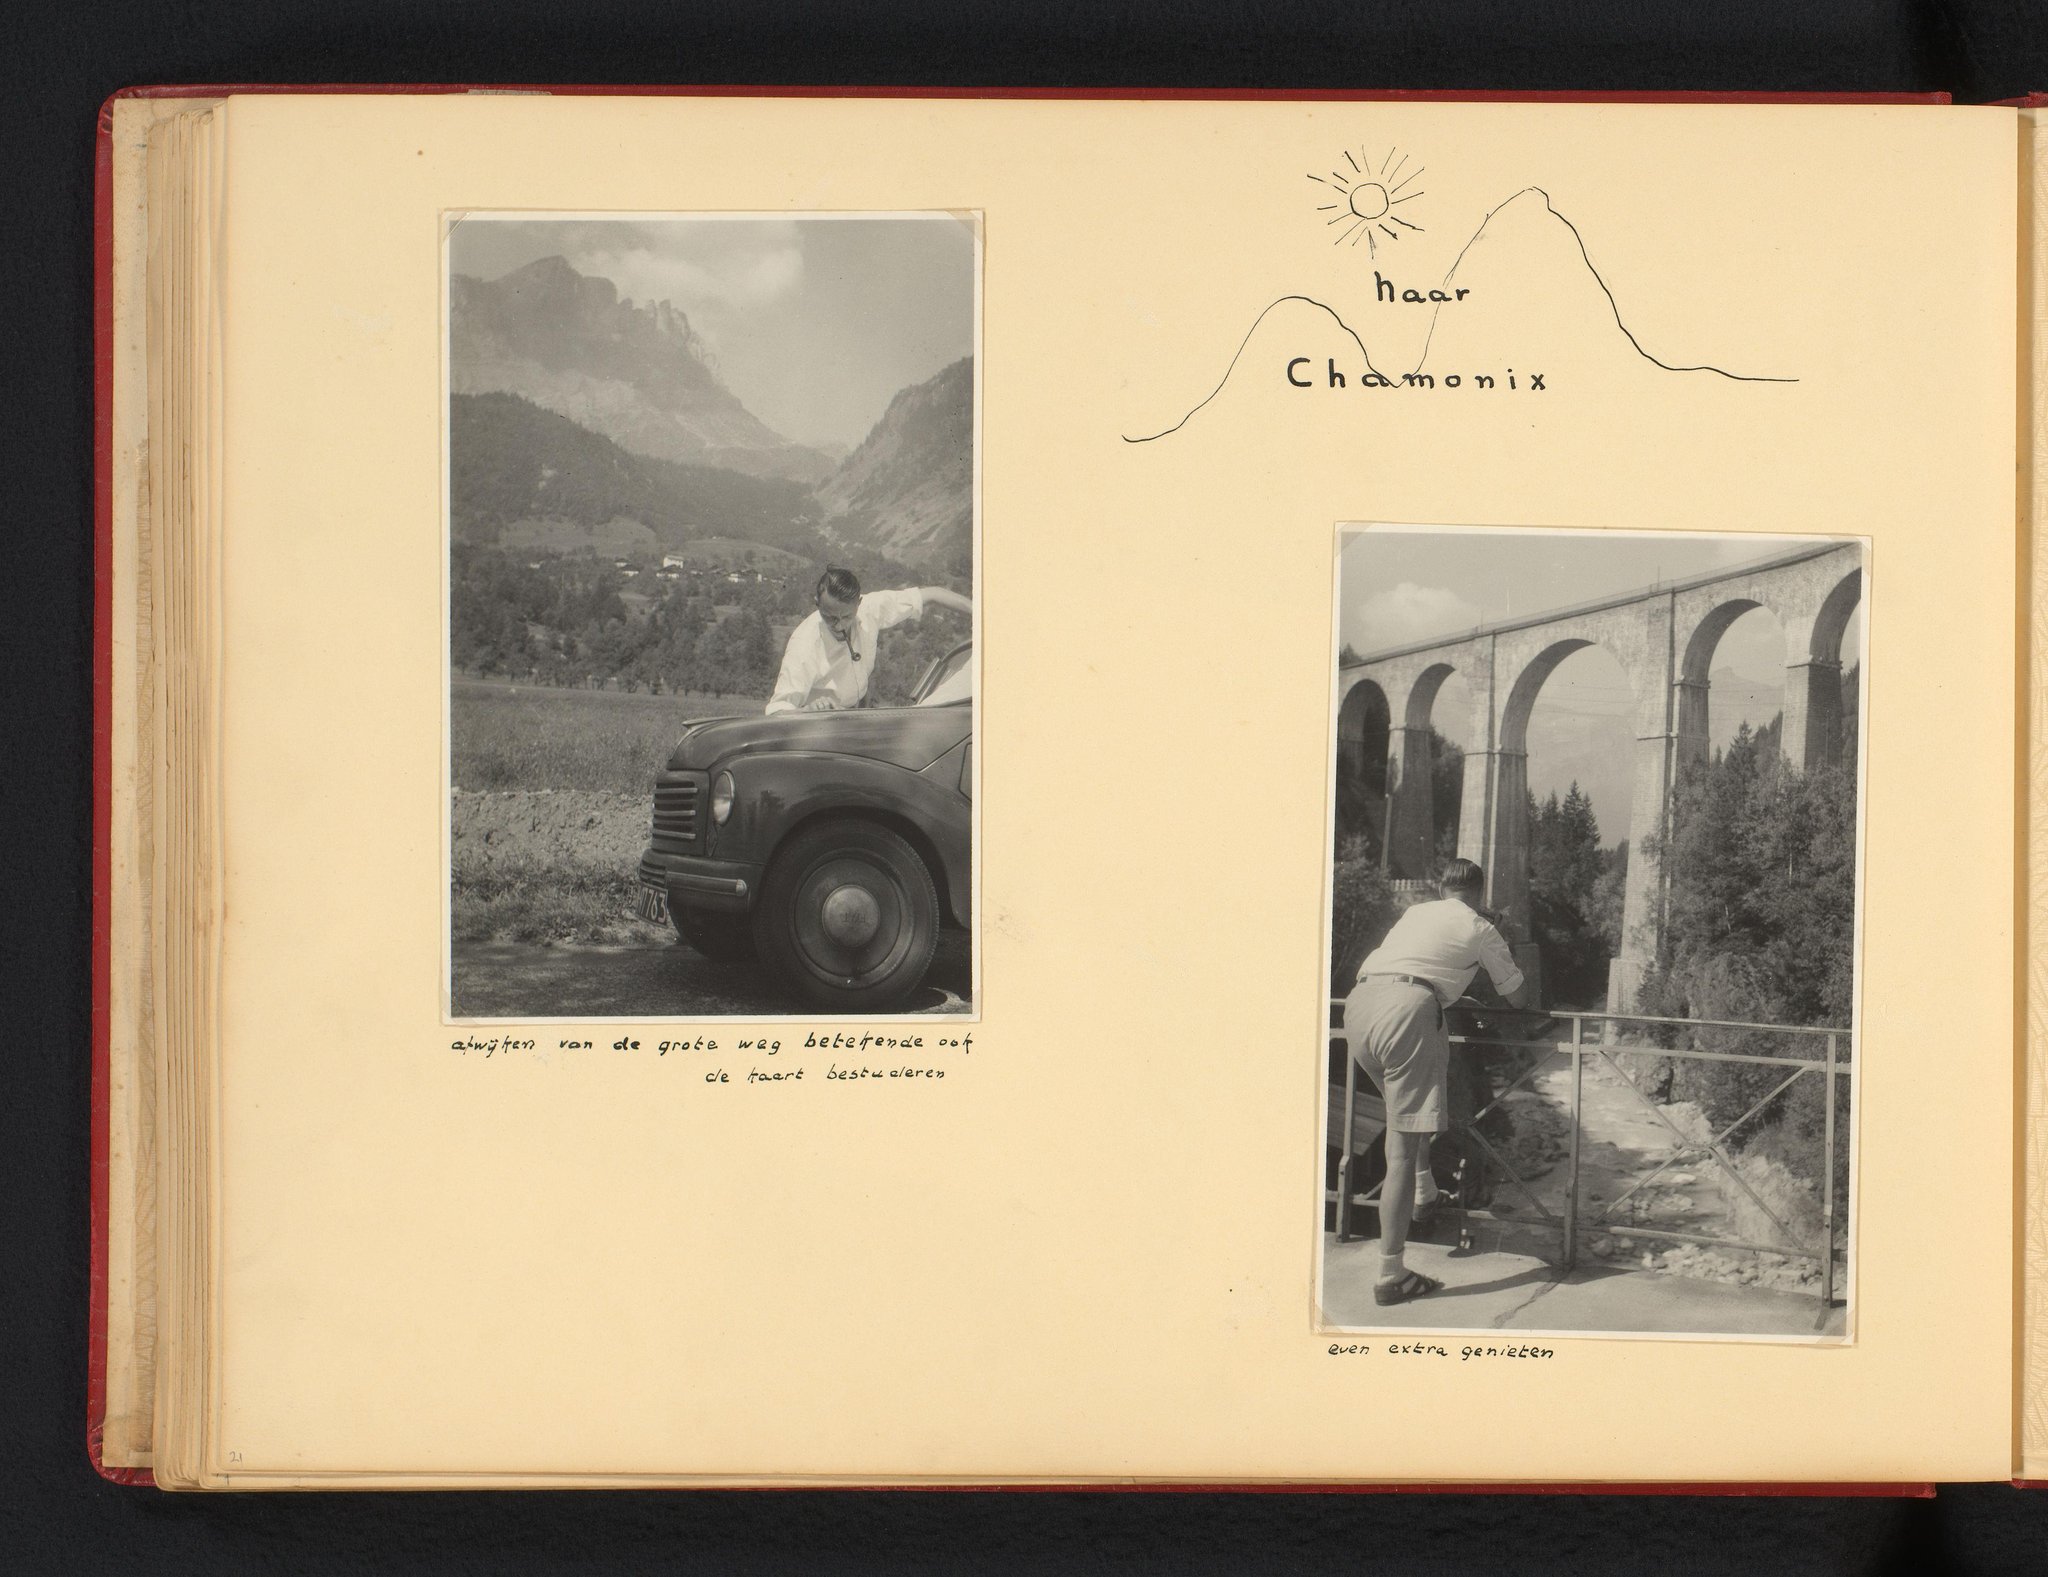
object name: album leaf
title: Naar Chamonix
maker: Anonymous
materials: paper, photographic support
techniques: gelatin silver print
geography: france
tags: the family travelling, on holiday, outing, pleasure trip, mountain-range, snow peaks, automobile, france, switzerland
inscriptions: inscription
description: Albumblad met twee foto's van de man bij een brug (plus een tweede losse afdruk) en bij de auto, onderweg naar Chamonix. Herinnering aan de vakantiereis van 31 augustus tot 11 september 1953. Onderdeel van het fotoalbum 'Met de Fiat 500 cabriolet op vakantie' met foto's van vakanties van een gezin tussen 1951-1959.